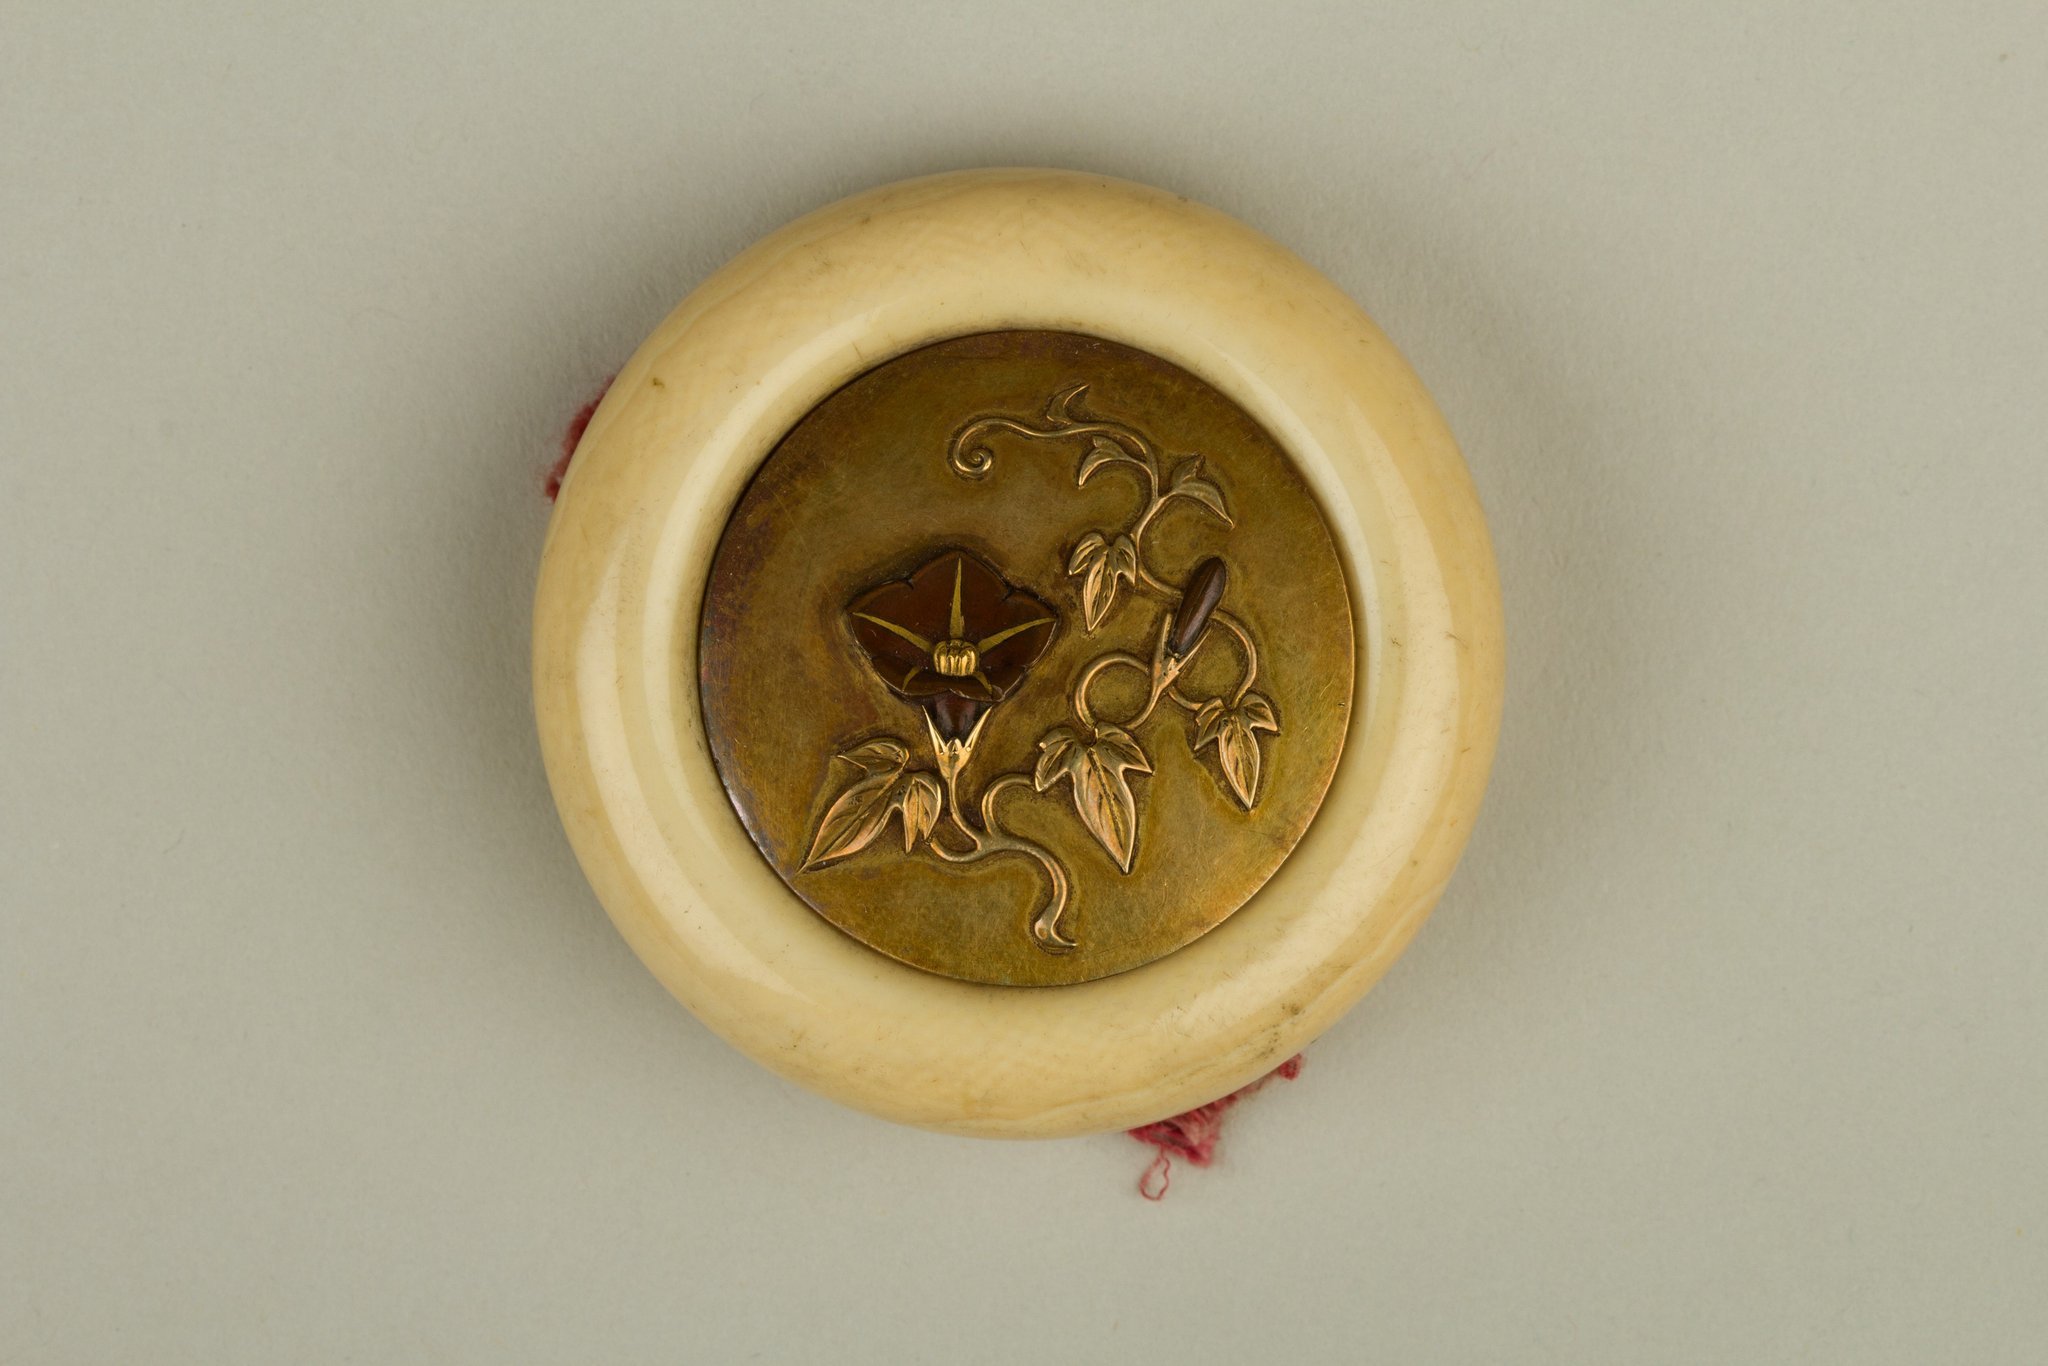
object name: netsuke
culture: japanese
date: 1801-1900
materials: ivory, metal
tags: flowers